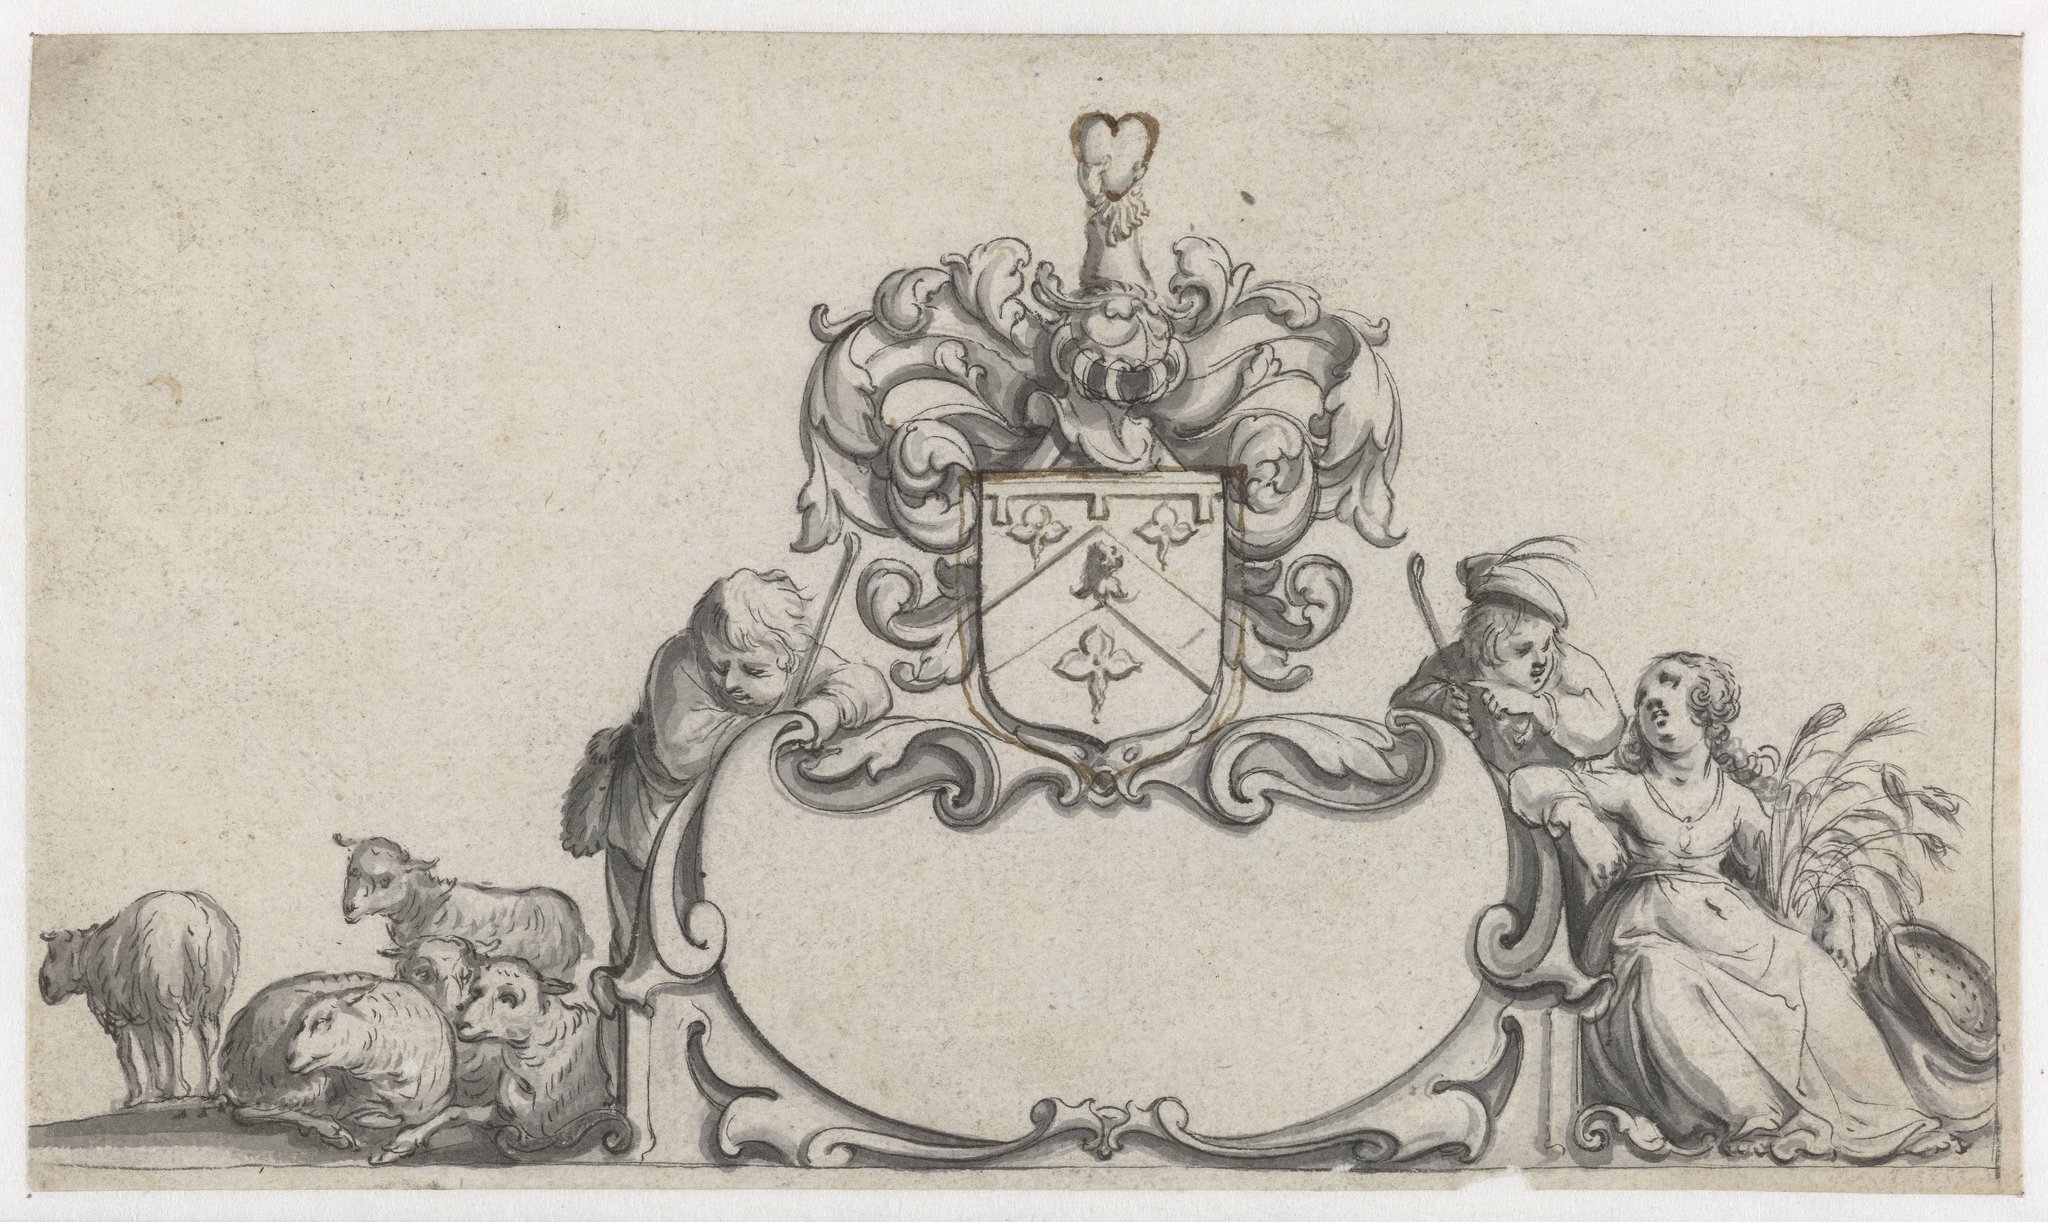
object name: design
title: Cartouche met het wapen van James Balfour of Denmiln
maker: pieter jansz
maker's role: draughtsman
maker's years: 1602-1672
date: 1649-1654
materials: ink, paper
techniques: brush, pen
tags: ornament ~ cartouche, assembly line, armorial bearing, heraldry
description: Cartouche omgeven door herders met schapen en bekroond met het wapen van James Balfour of Denmiln. Ontwerp voor een prent.